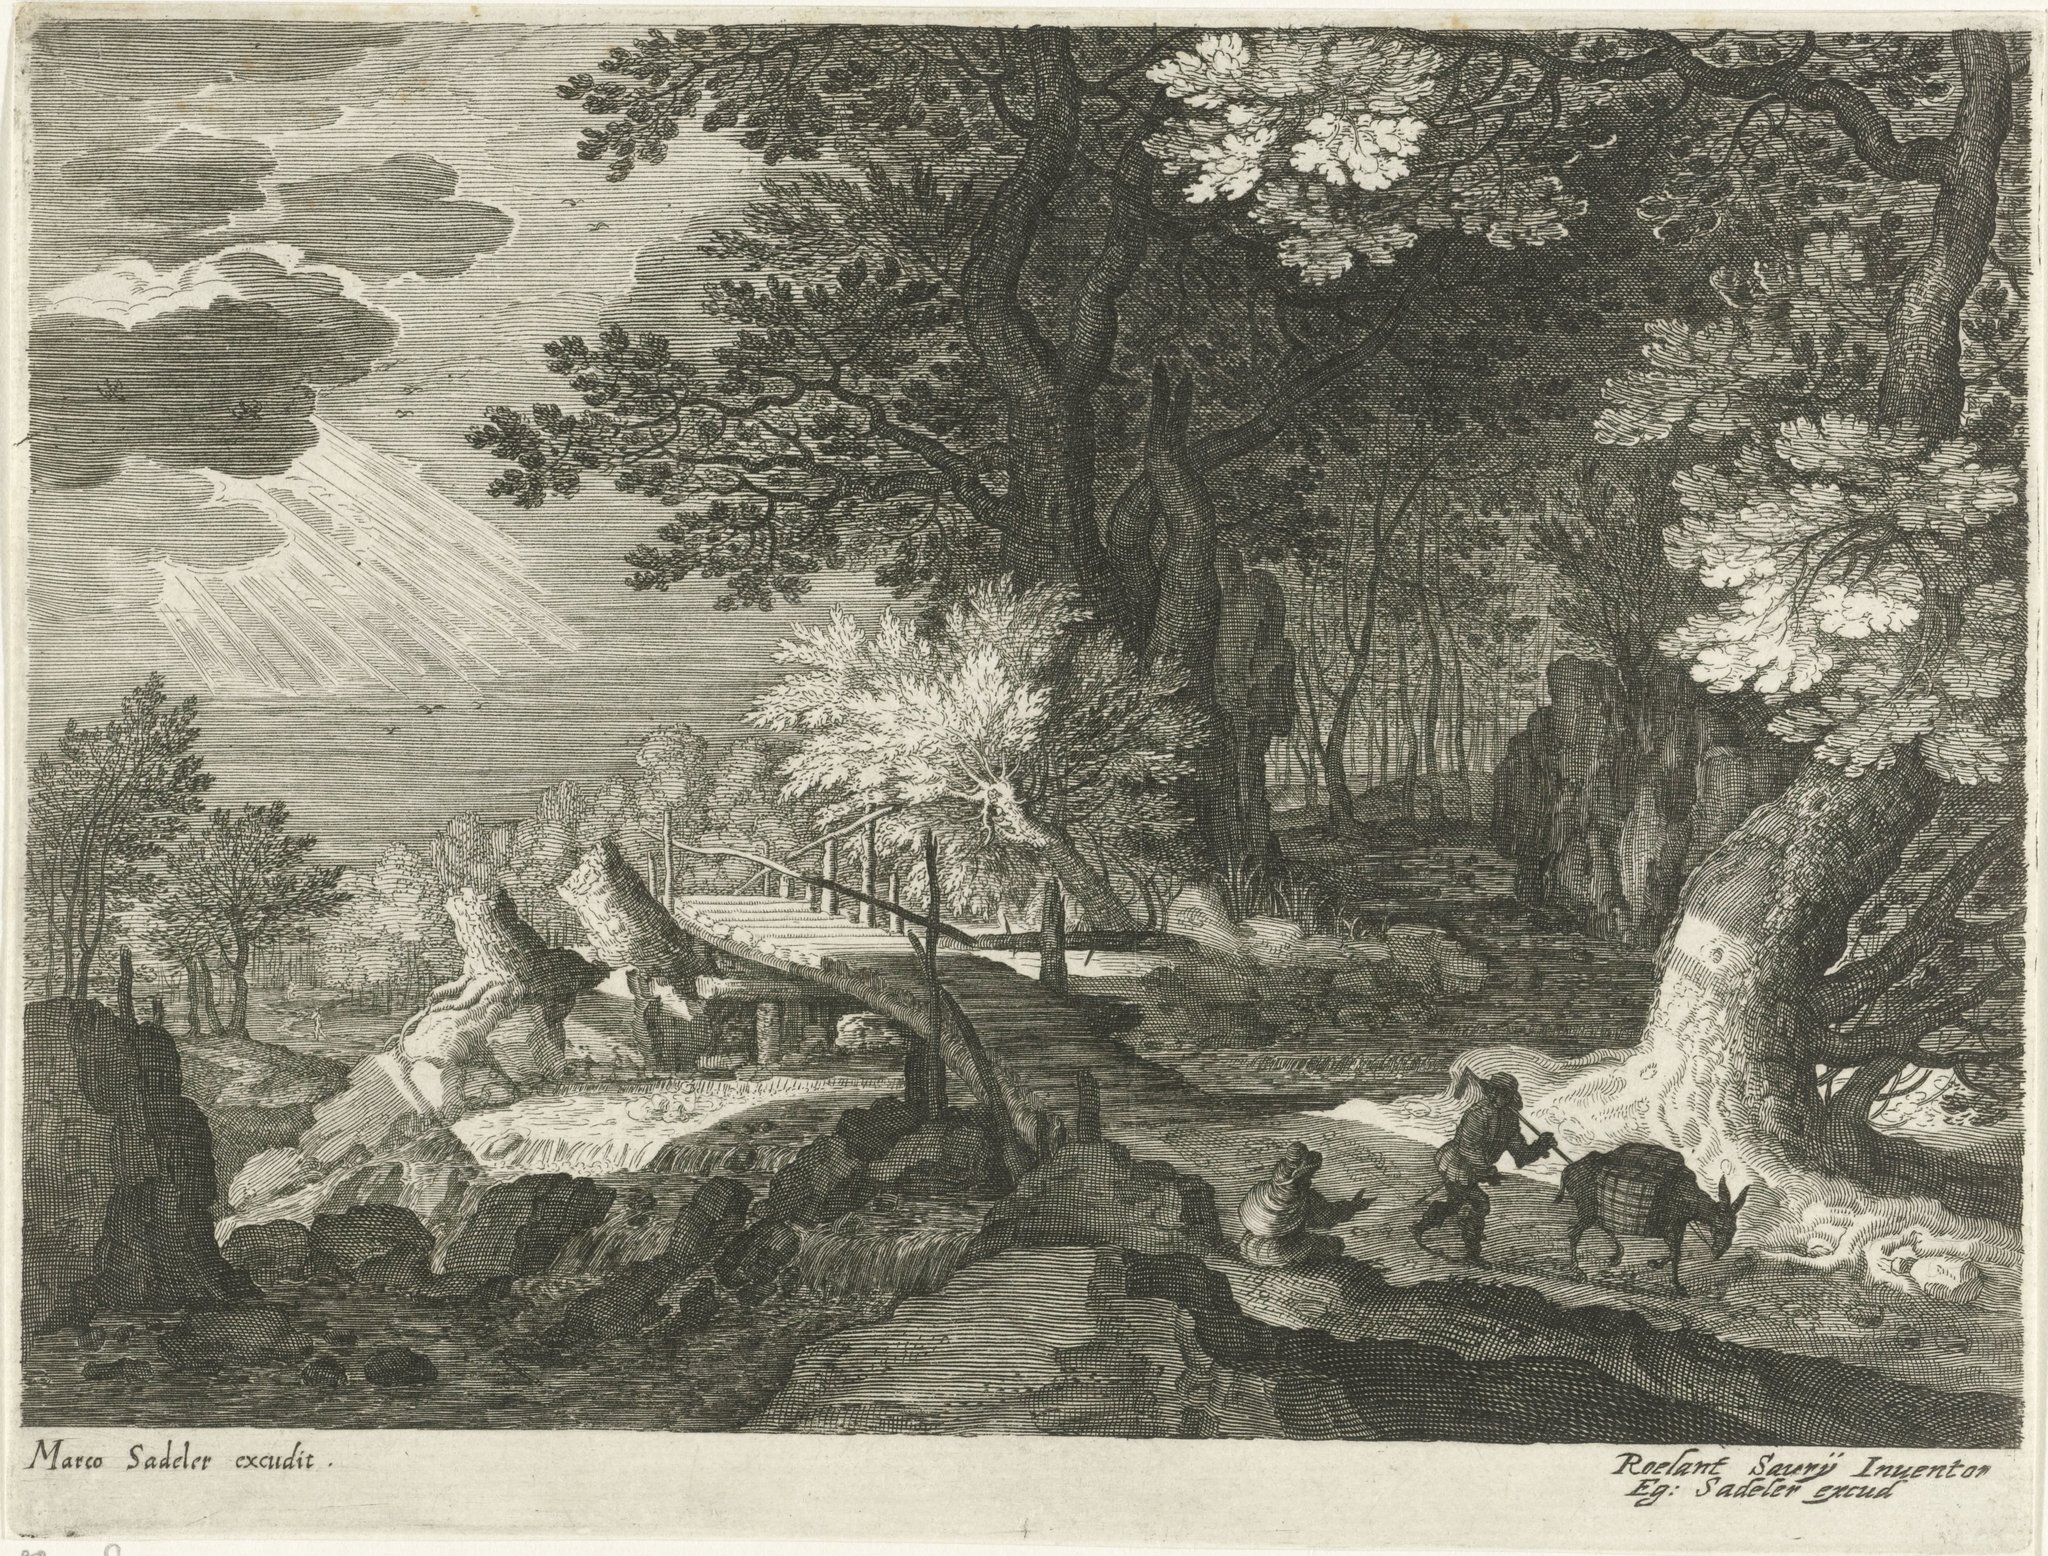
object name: print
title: Houten brug in een boslandschap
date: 1580-1629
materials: paper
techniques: engraving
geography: venice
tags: forest, wood, 'en route', traveller under way, landscape with bridge, viaduct or aqueduct (+ city(-scape) with figures, staffage)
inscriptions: collector's mark: Lugt 240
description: Boslandschap met op de voorgrond een bosweg waarop een man met ezel en zittende reiziger. Links een houten brug over een rivier. De vierde prent van een zesdelige reeks met landschappen uit Tirol.